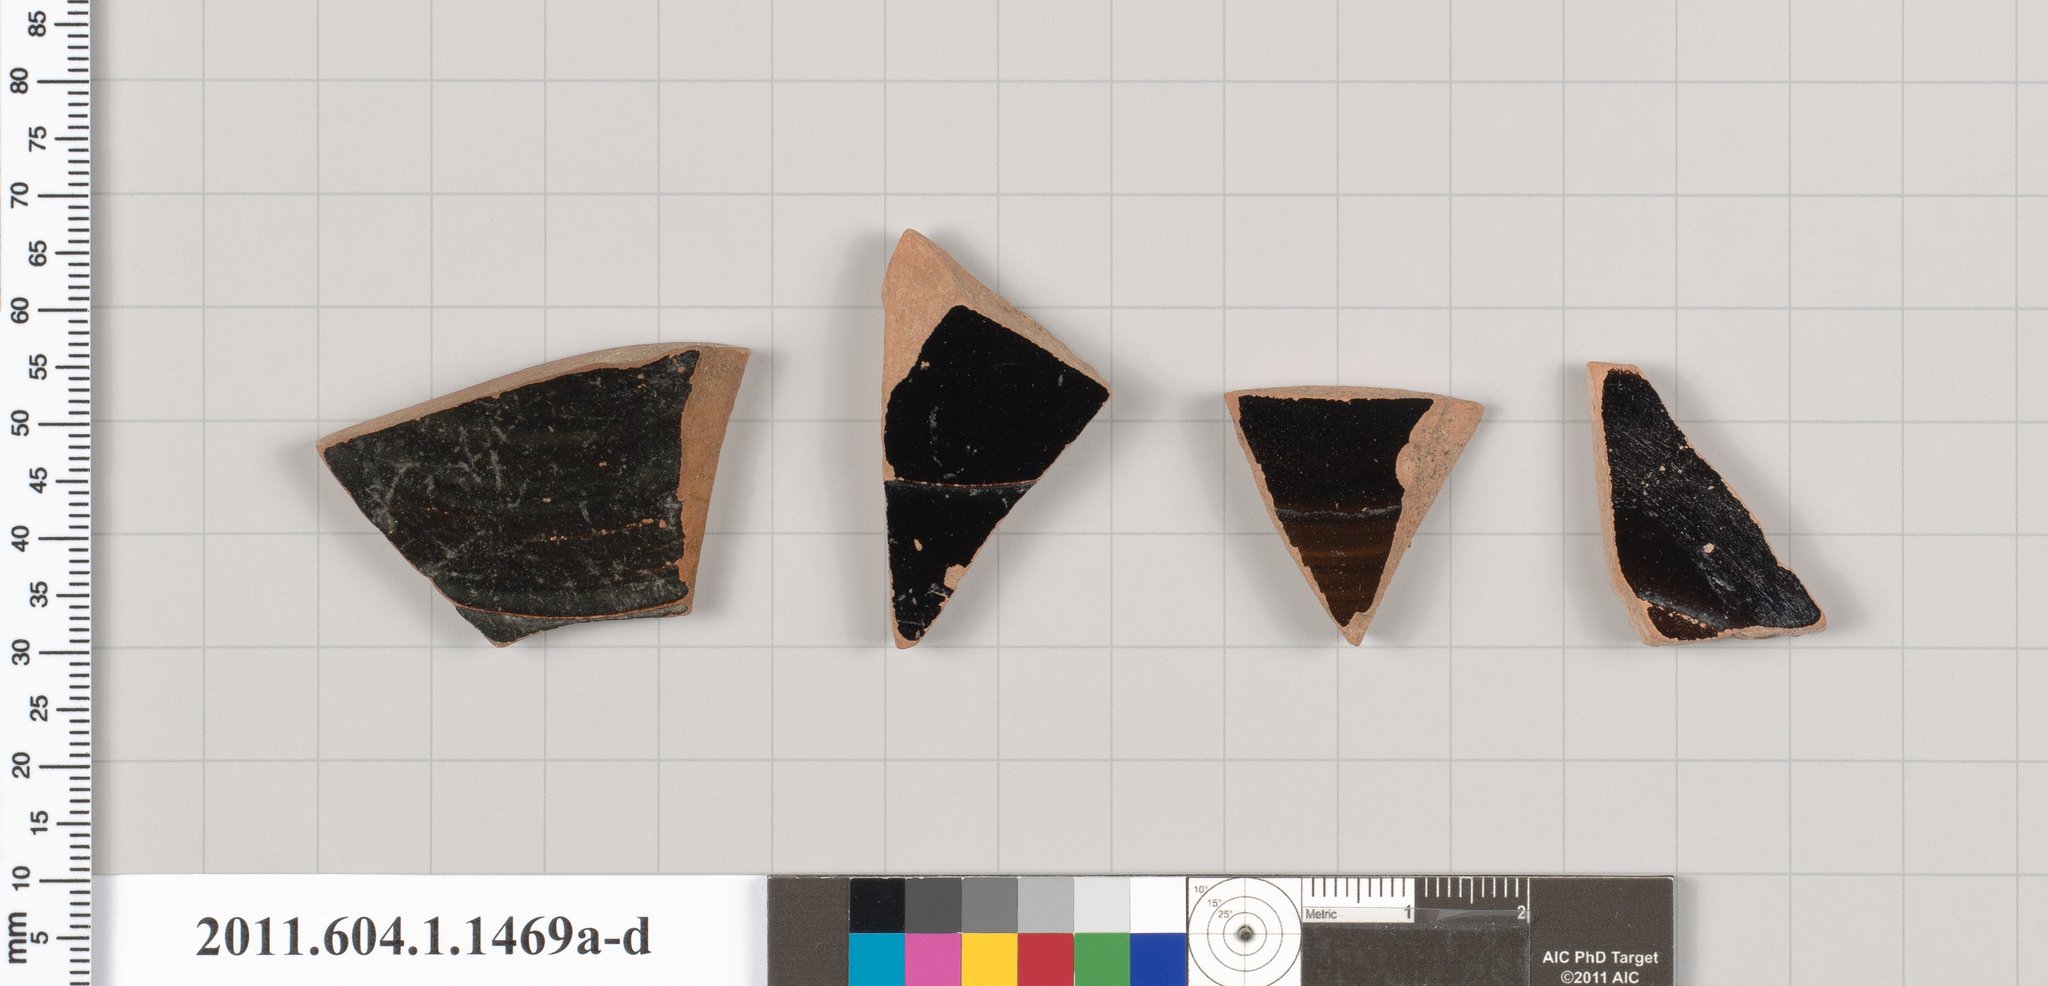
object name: kylix fragment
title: Terracotta fragments of kylikes (drinking cups)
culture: greek, attic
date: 500-401 BCE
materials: terracotta